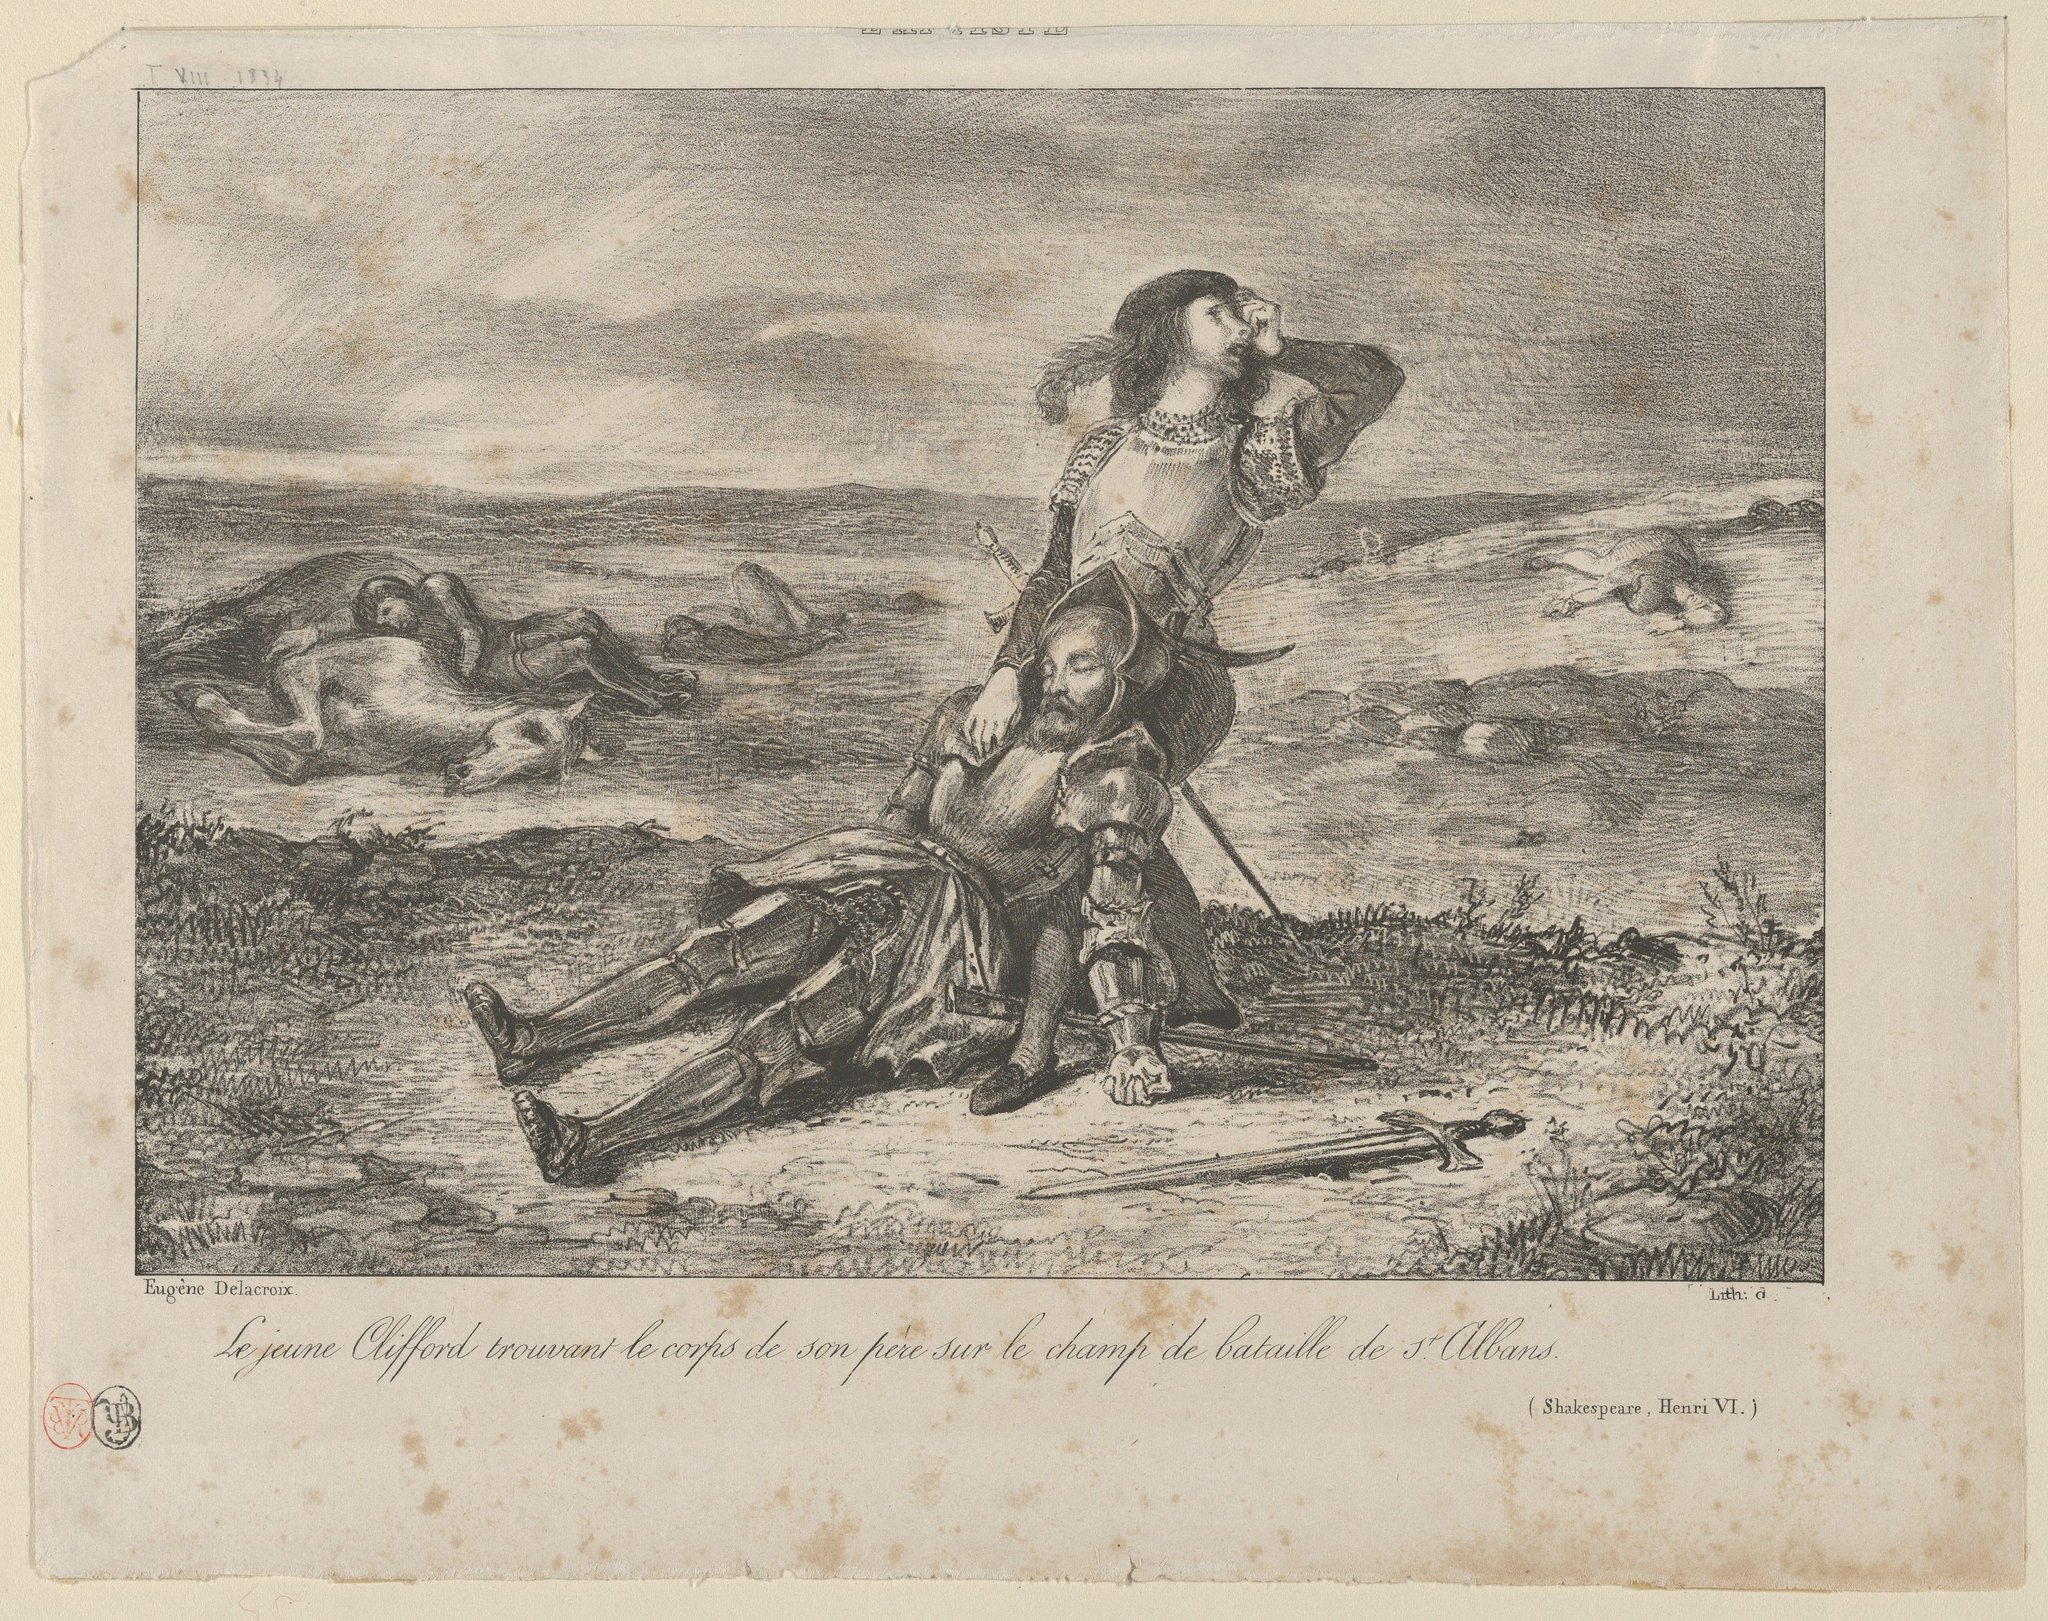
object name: print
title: Young Clifford Finding the Body of his Father, from "L'Artiste"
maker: eugène delacroix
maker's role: artist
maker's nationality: french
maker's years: 1798-1863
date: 1834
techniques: lithograph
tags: animals,swords,men,fathers,death